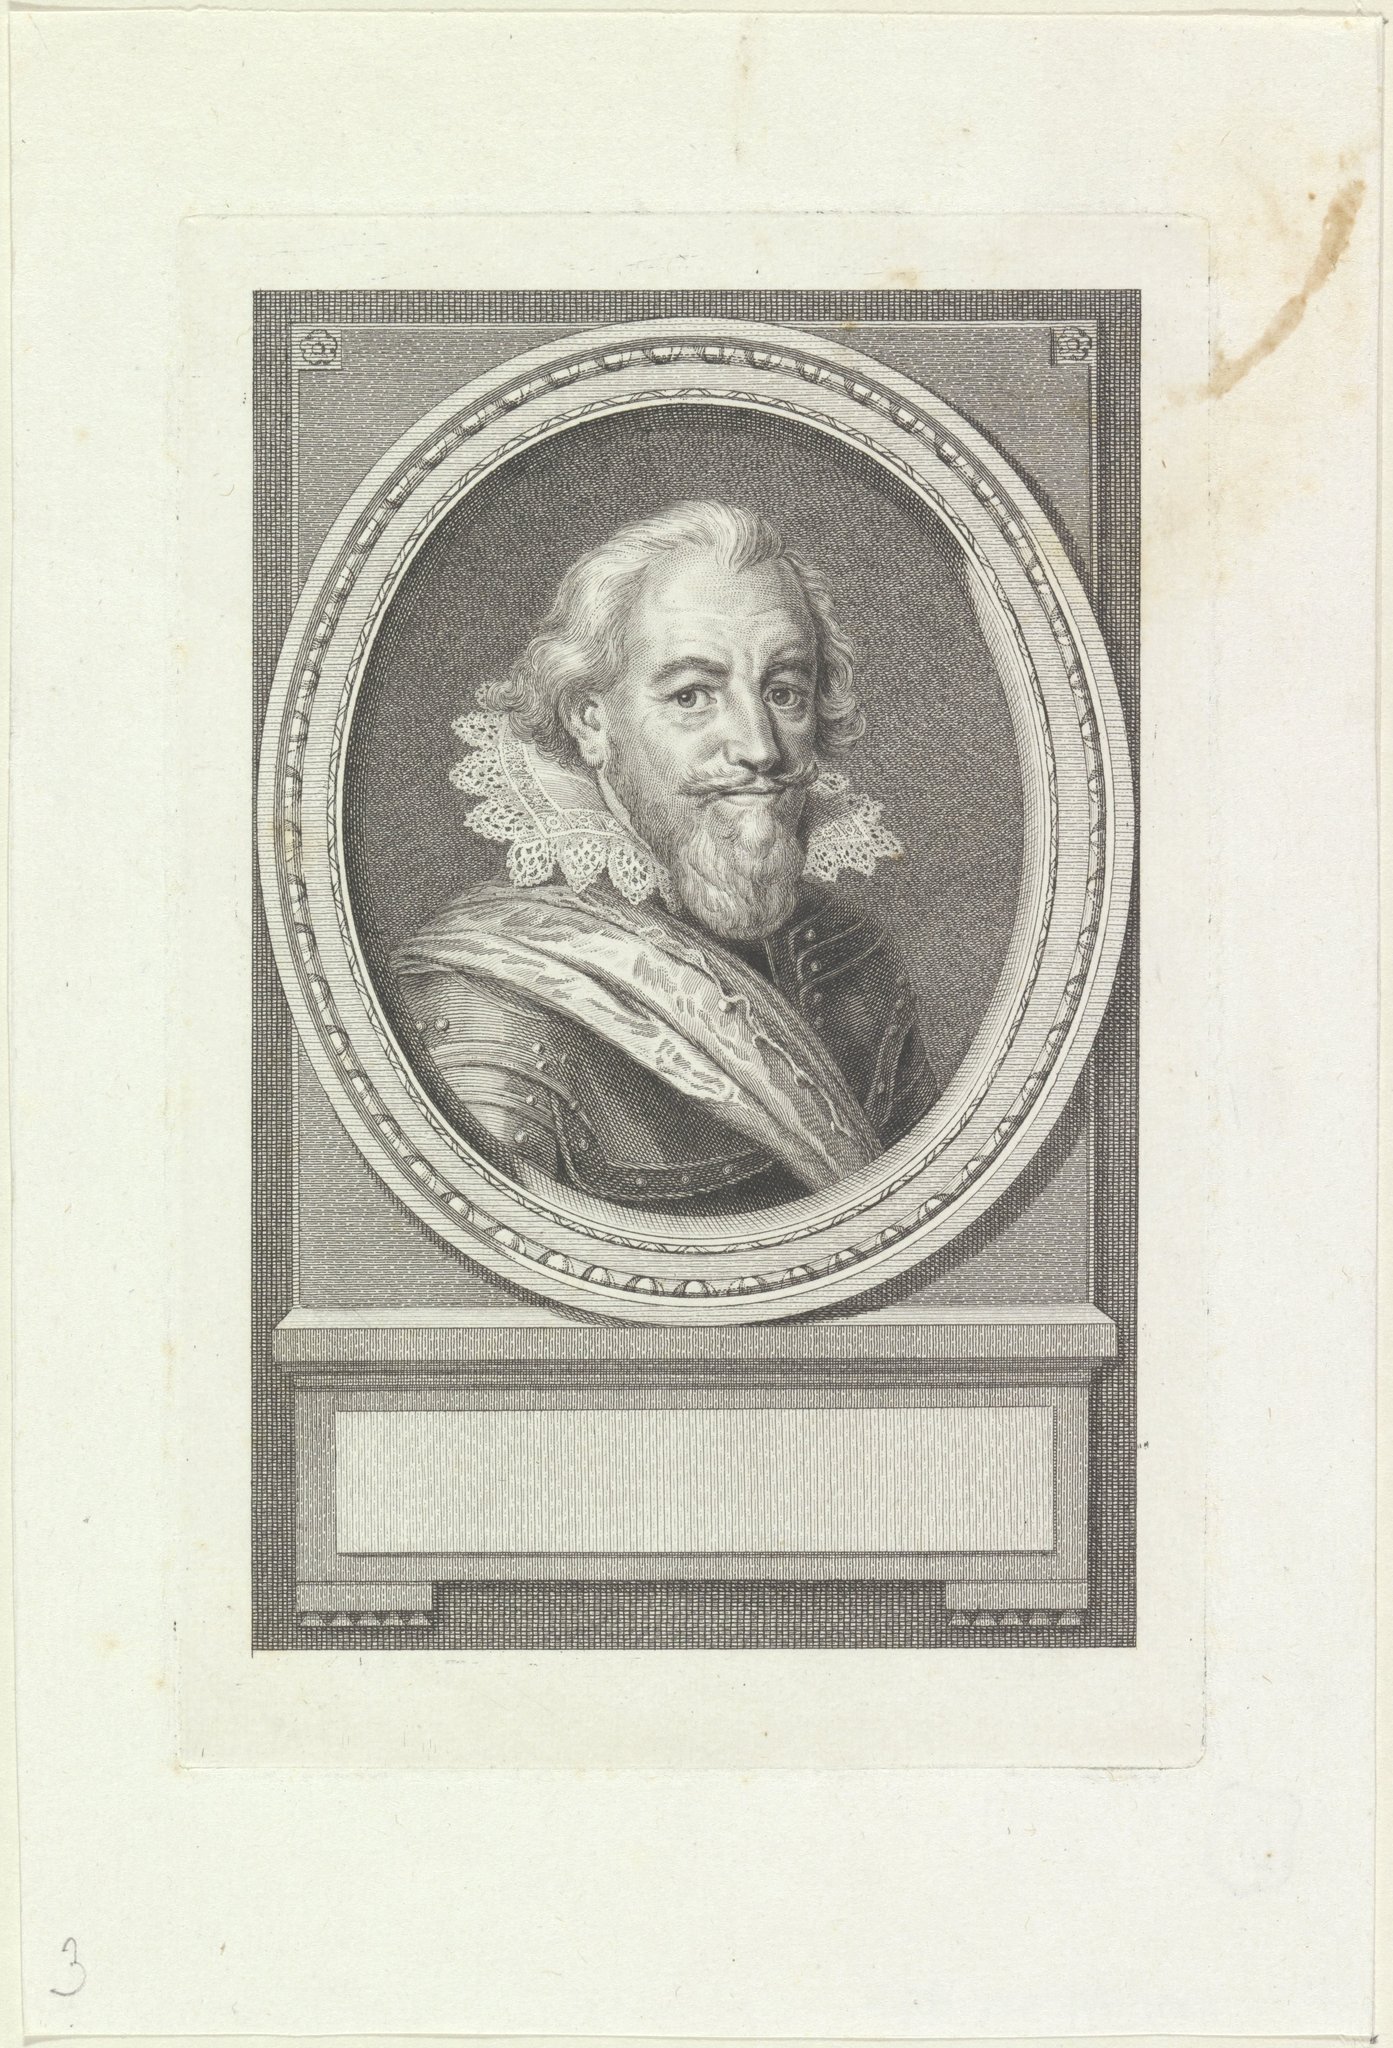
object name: print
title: Portret van Johan VII, graaf van Nassau-Siegen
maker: reinier vinkeles (i)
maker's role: draughtsman, print maker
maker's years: 1741-1816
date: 1762-1816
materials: paper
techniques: engraving, etching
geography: amsterdam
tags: dillenburg, johan vii graaf van nassau-siegen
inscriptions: collector's mark: Lugt 963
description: De hier vermelde titel verwijst naar de hoogst verkregen titel van de geportretteerde, niet per se naar de titel die de geportretteerde op deze voorstelling draagt.